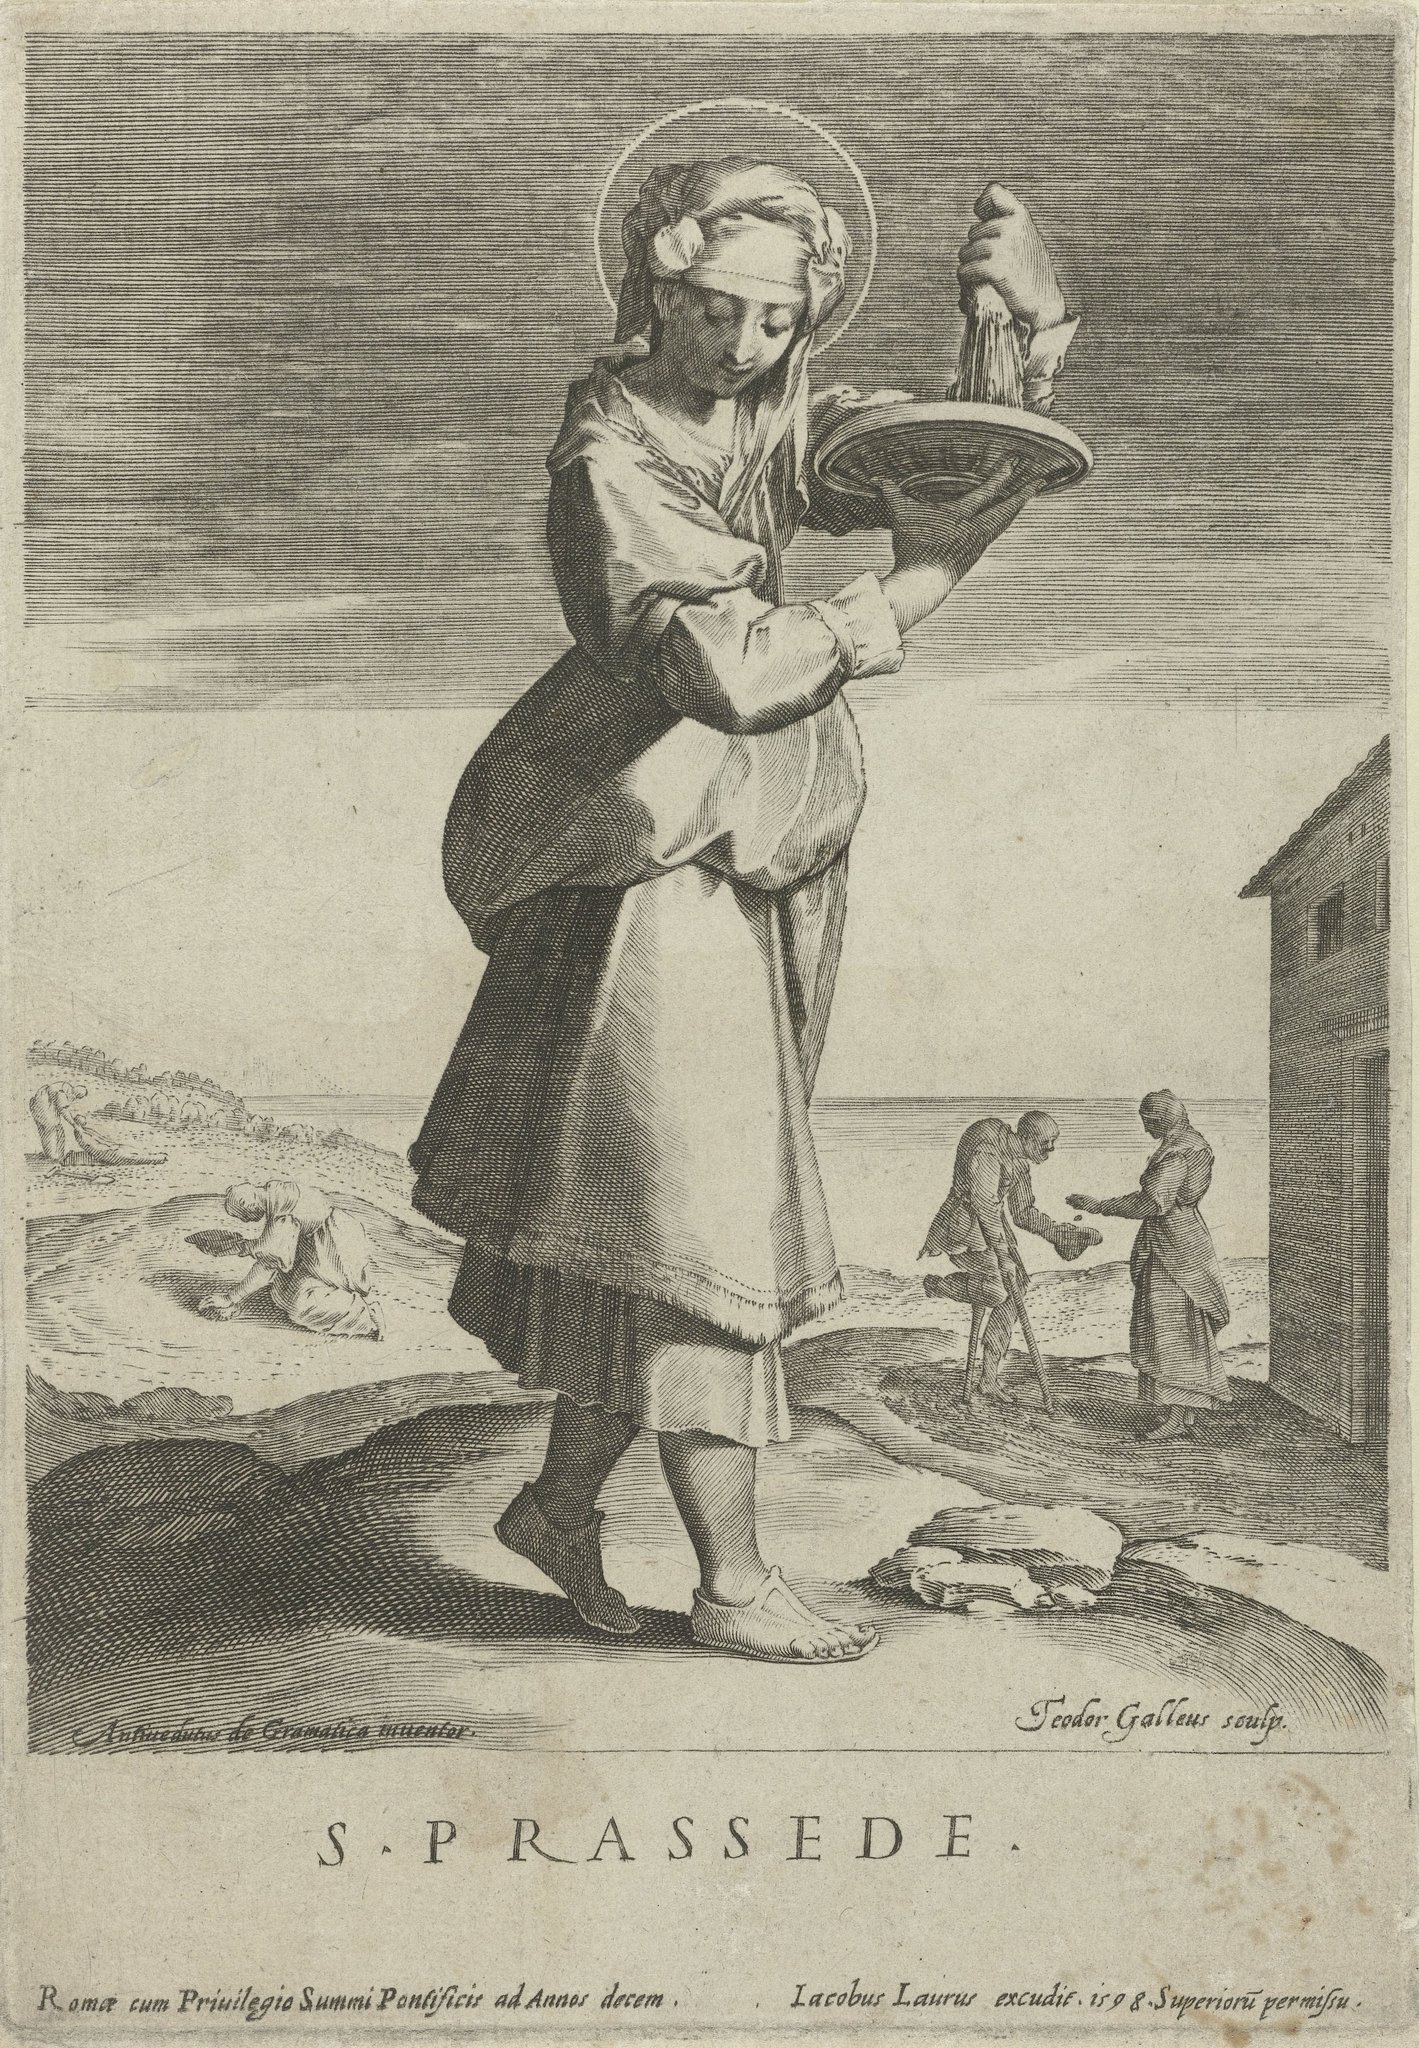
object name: print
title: Heilige Praxedis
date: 1598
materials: paper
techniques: engraving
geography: rome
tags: female saints (with name)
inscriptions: collector's mark: Lugt 240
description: De heilige Praxedis met in haar handen vaatwerk waarin ze een spons met bloed uitknijpt. Op de achtergrond ontdoet ze met haar spons de aarde van martelaarsbloed. Erachter wordt een martelaar begraven.